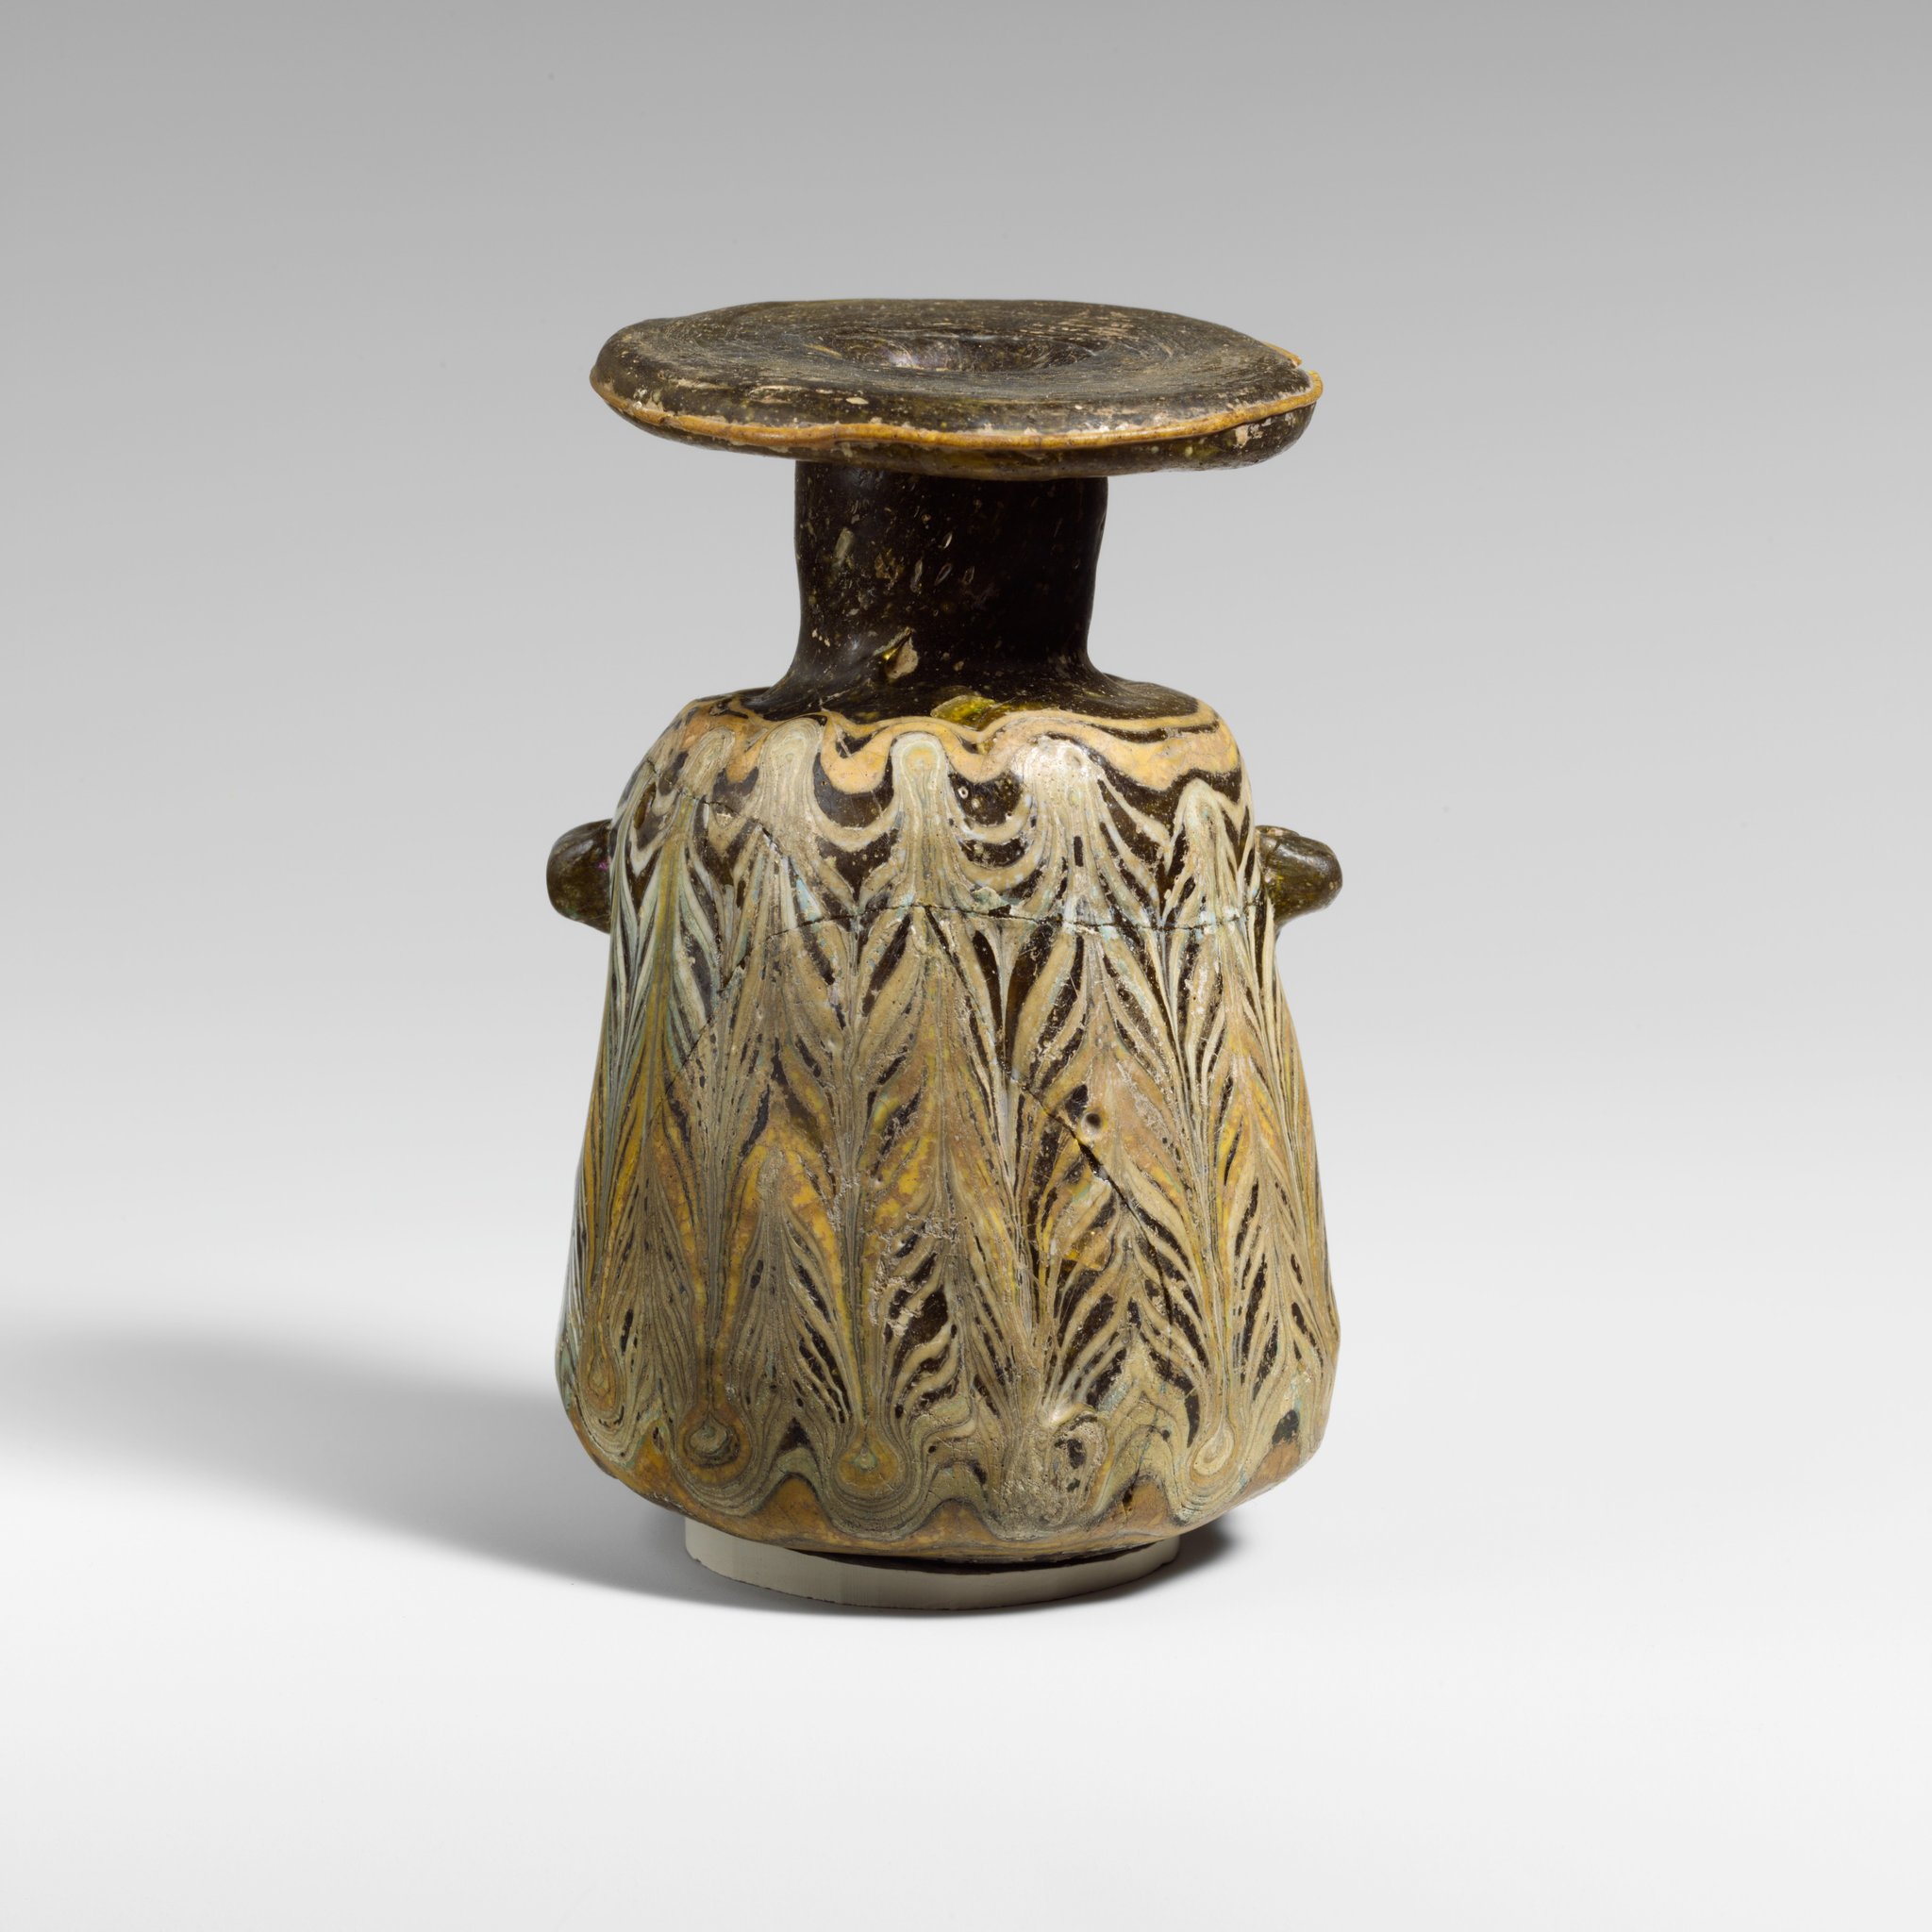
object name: alabastron, squat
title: Glass squat alabastron (perfume bottle)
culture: eastern mediterranean or italian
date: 334-268 BCE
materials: glass